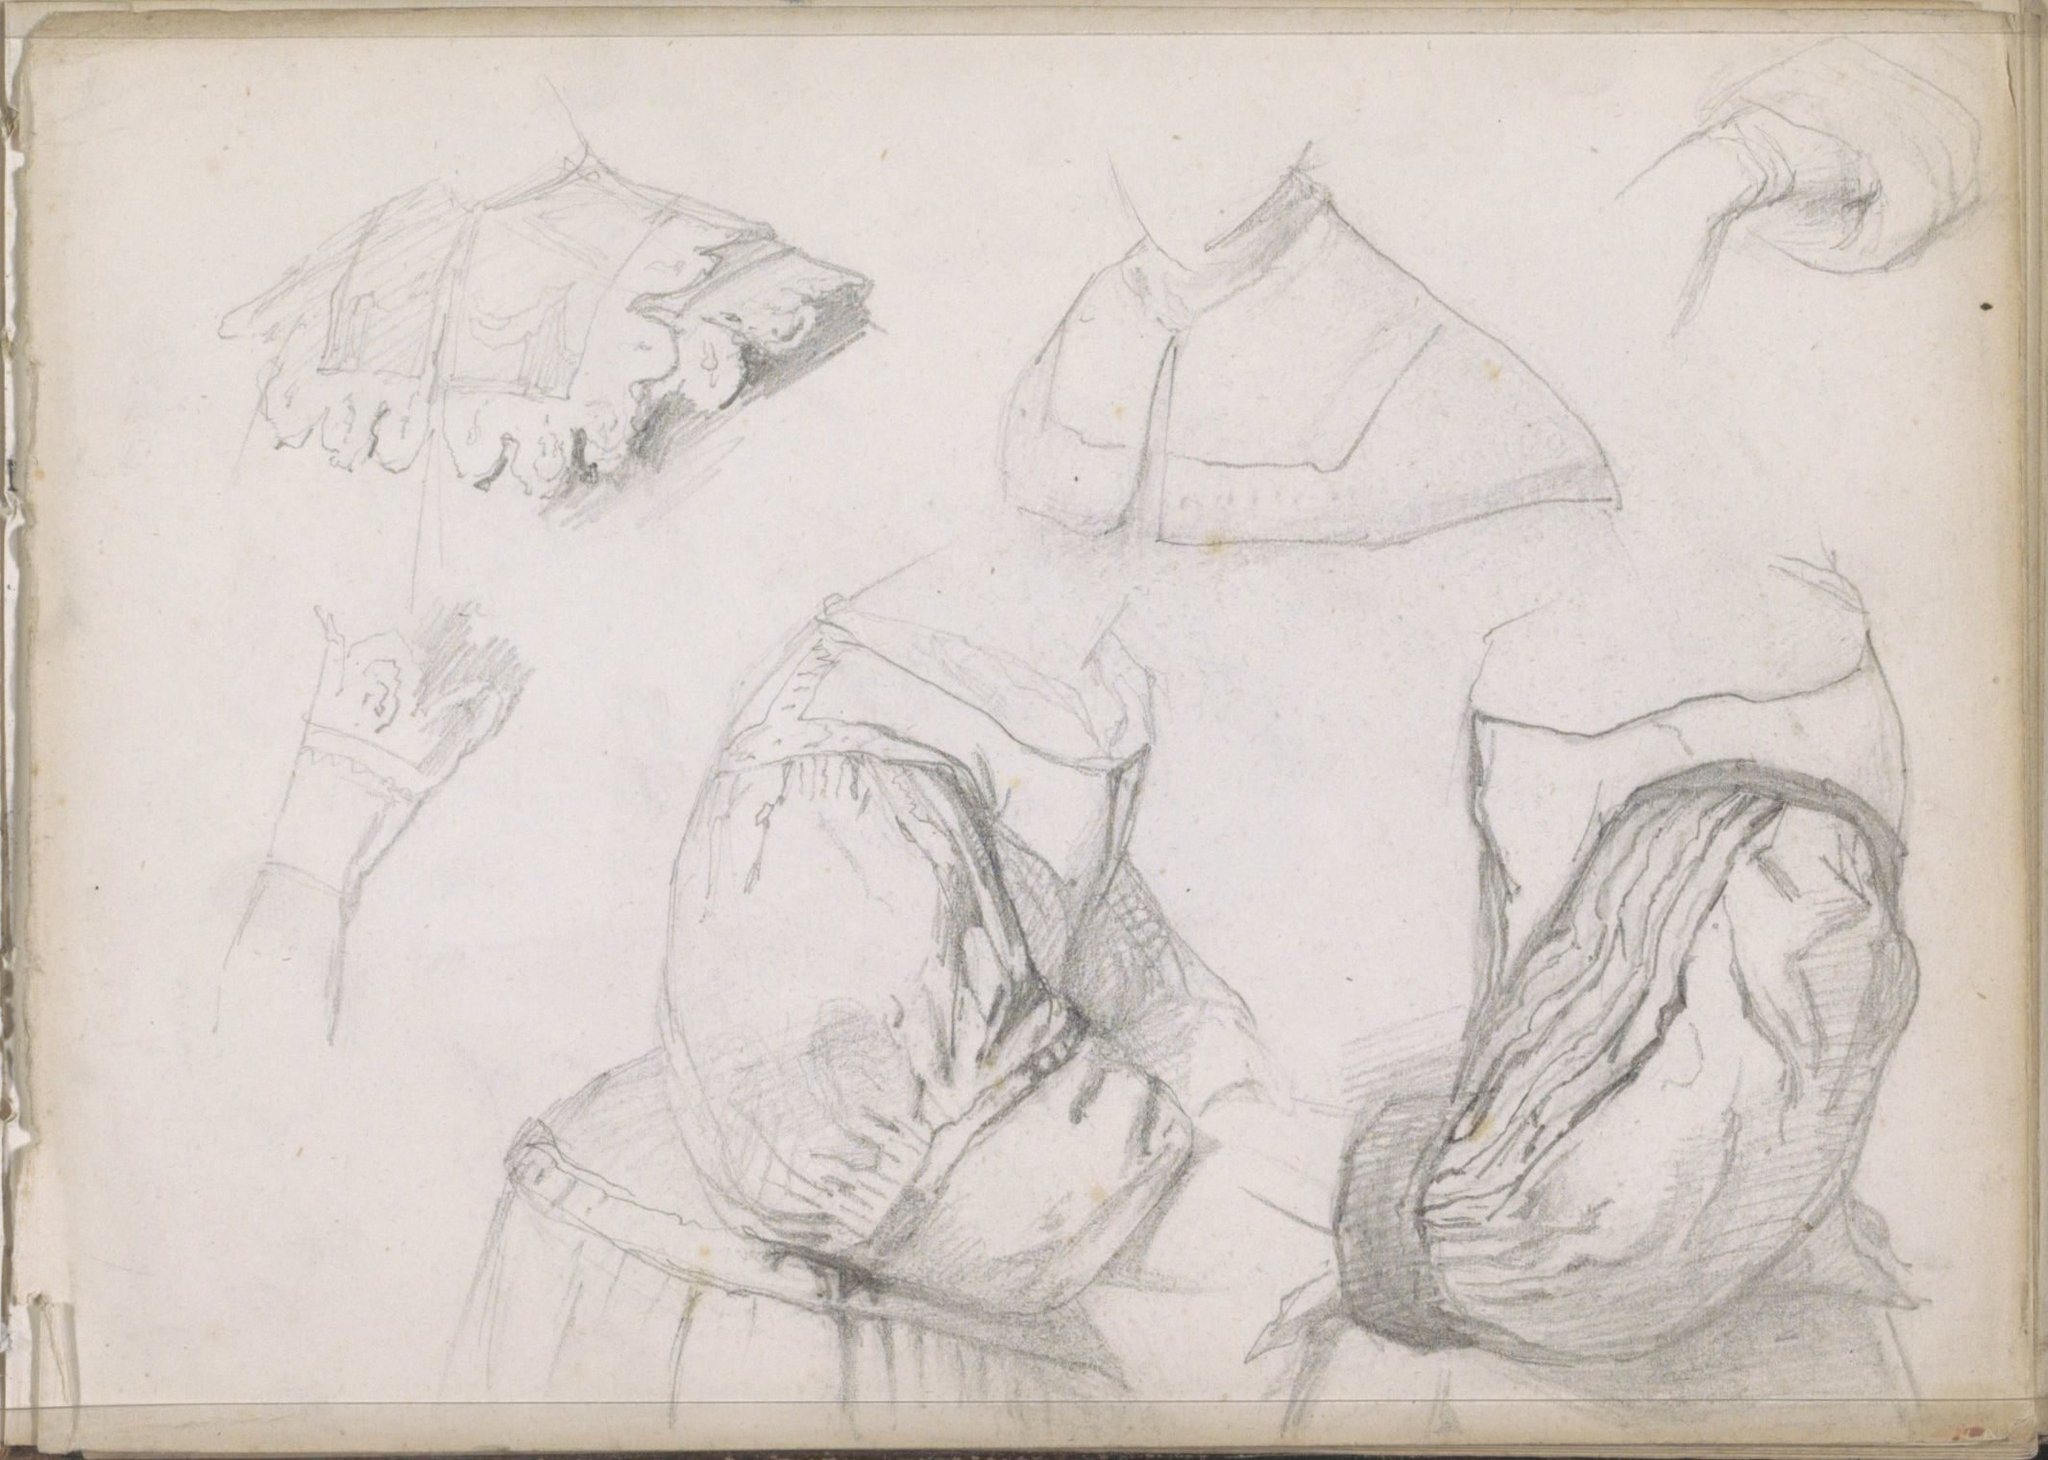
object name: sketchbook leaf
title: Dameskleding, waaronder kragen, mouwen en japonnen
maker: maria vos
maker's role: draughtsman, painter, print maker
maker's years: 1824-1906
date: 1834-1906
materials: paper, pencil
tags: fashion, clothing (+ women's clothes)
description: Blad 5 recto uit een schetsboek met 30 bladen.